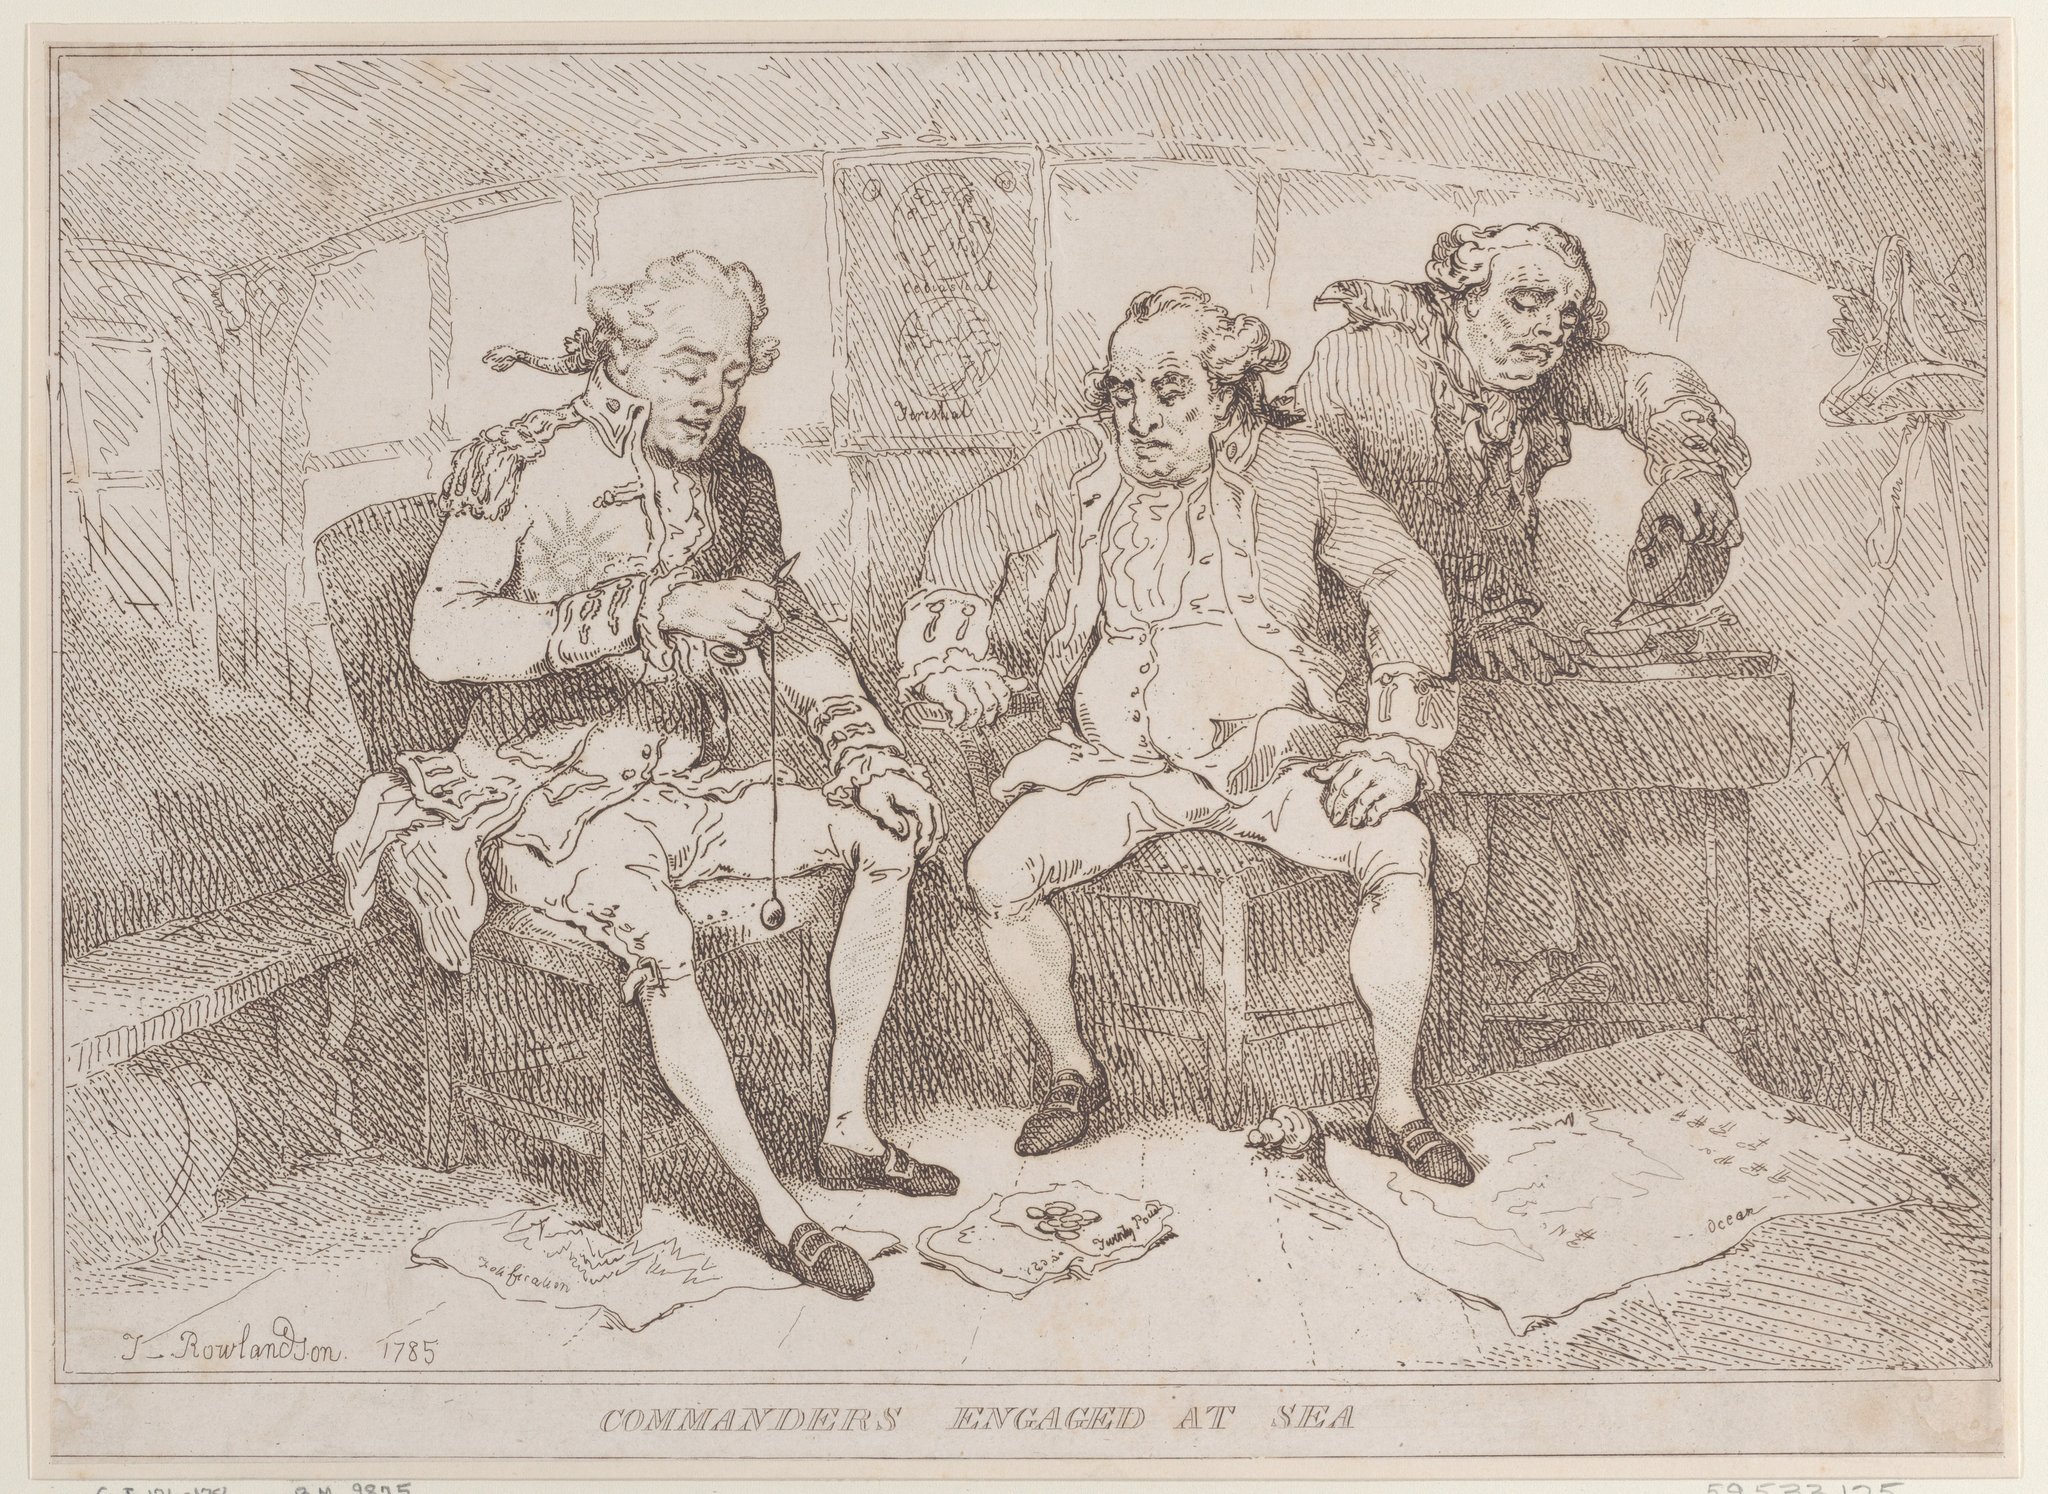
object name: print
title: Commanders Engaged at Sea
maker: thomas rowlandson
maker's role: artist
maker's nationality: british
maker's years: 1757-1827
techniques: etching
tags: satire,men,gambling